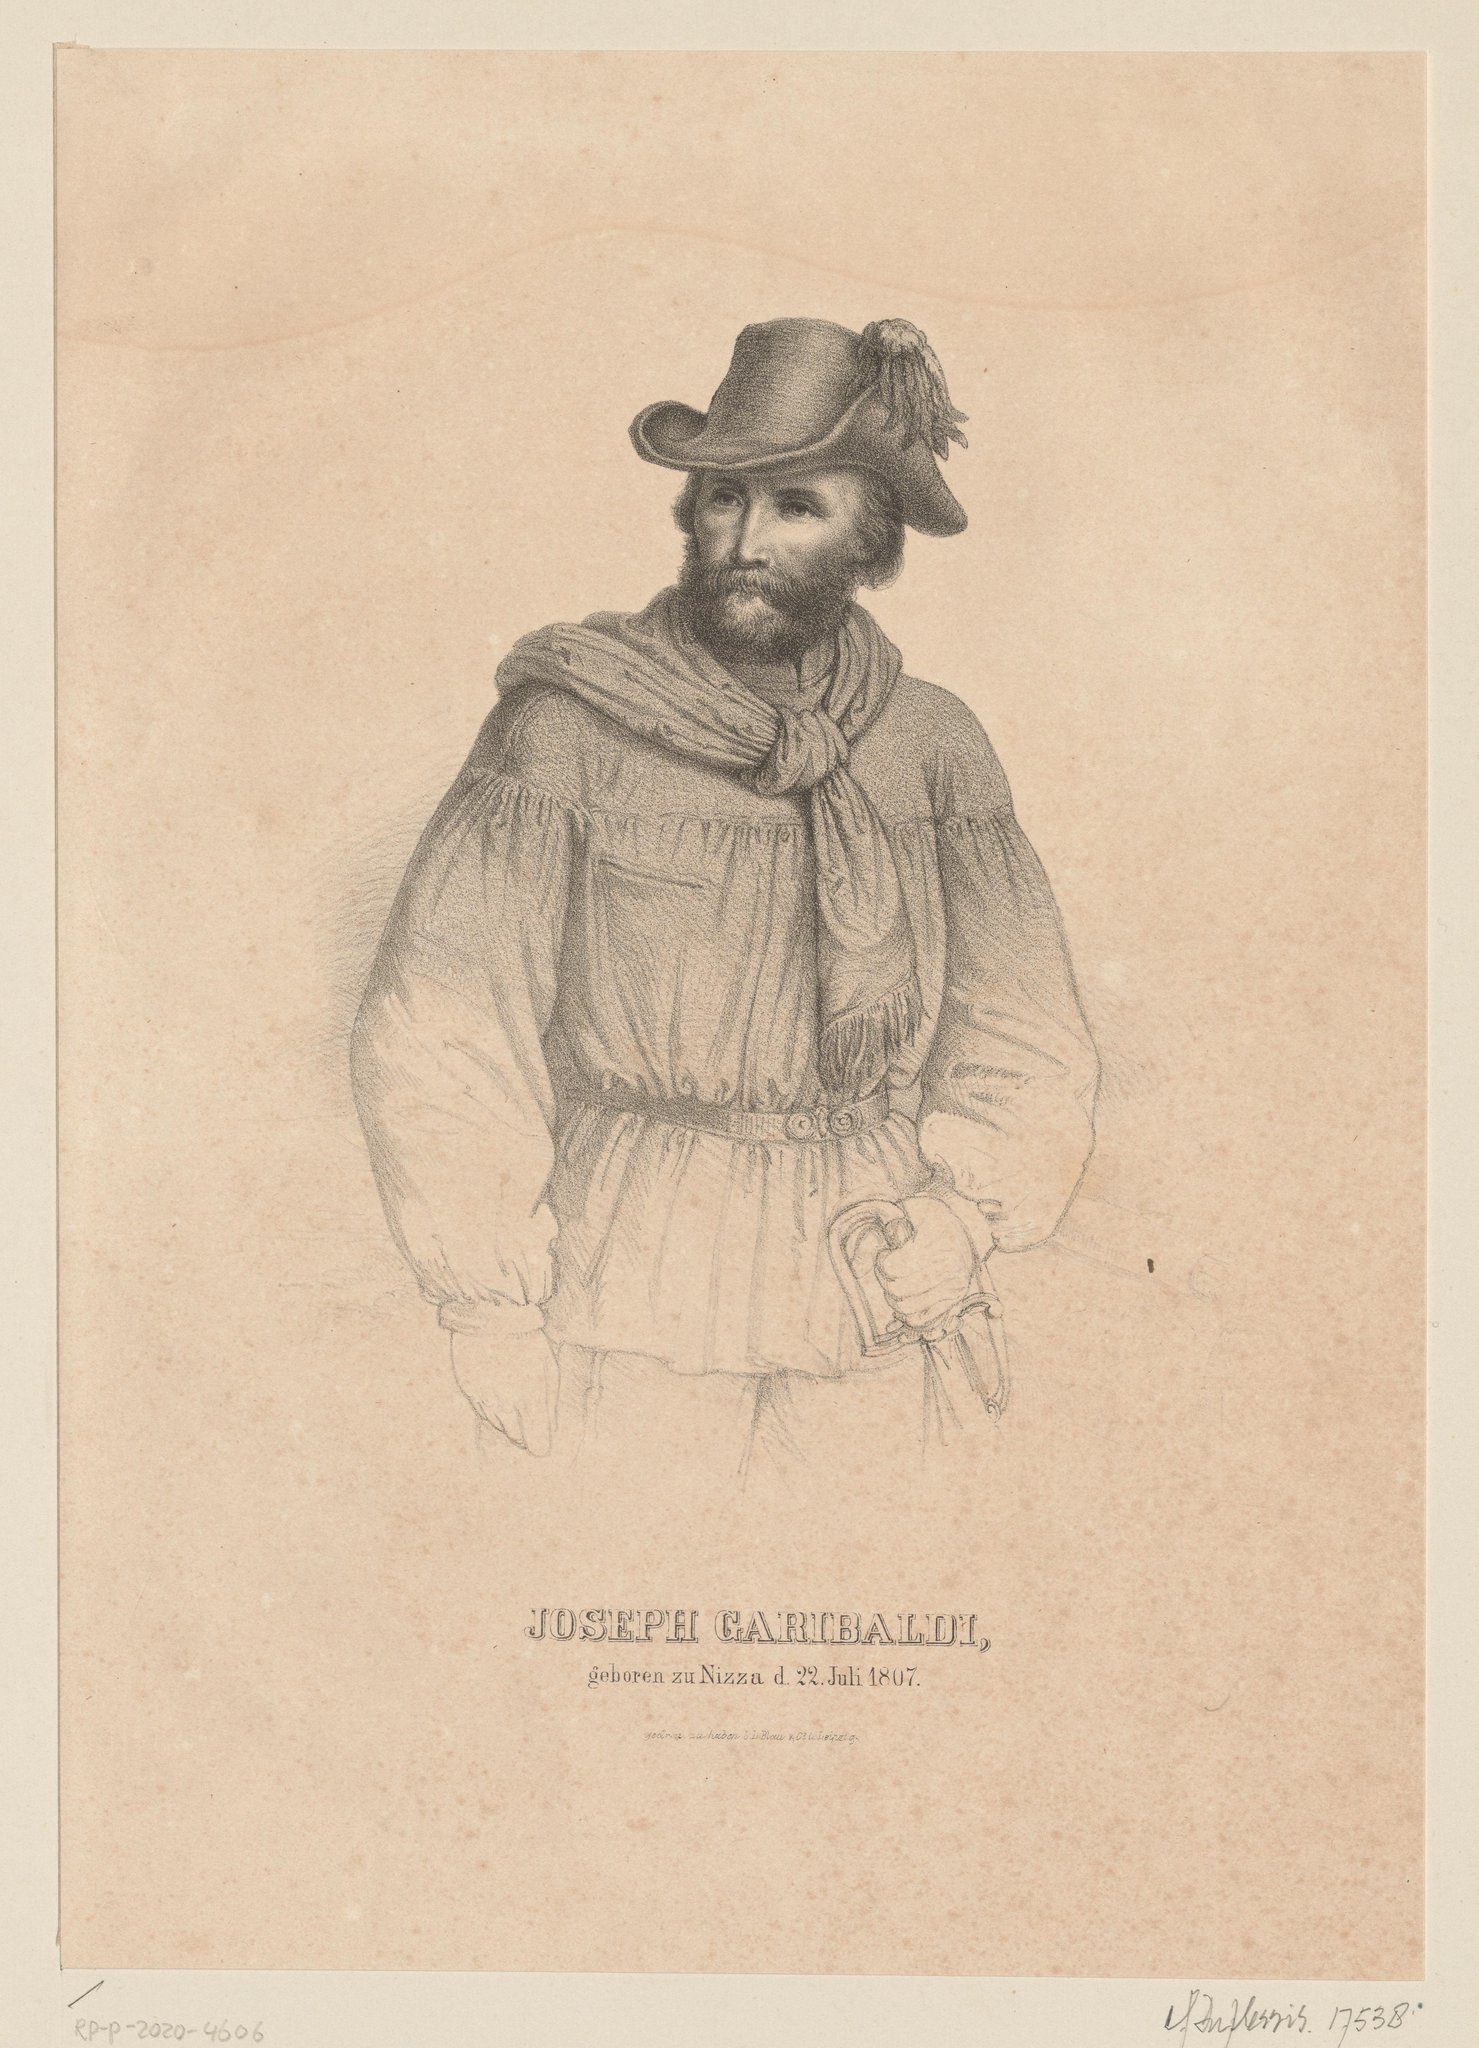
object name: print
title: Portret van Giuseppe Garibaldi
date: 1867-1940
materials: paper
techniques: lithograph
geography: leipzig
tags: commander-in-chief, general, marshal, historical persons